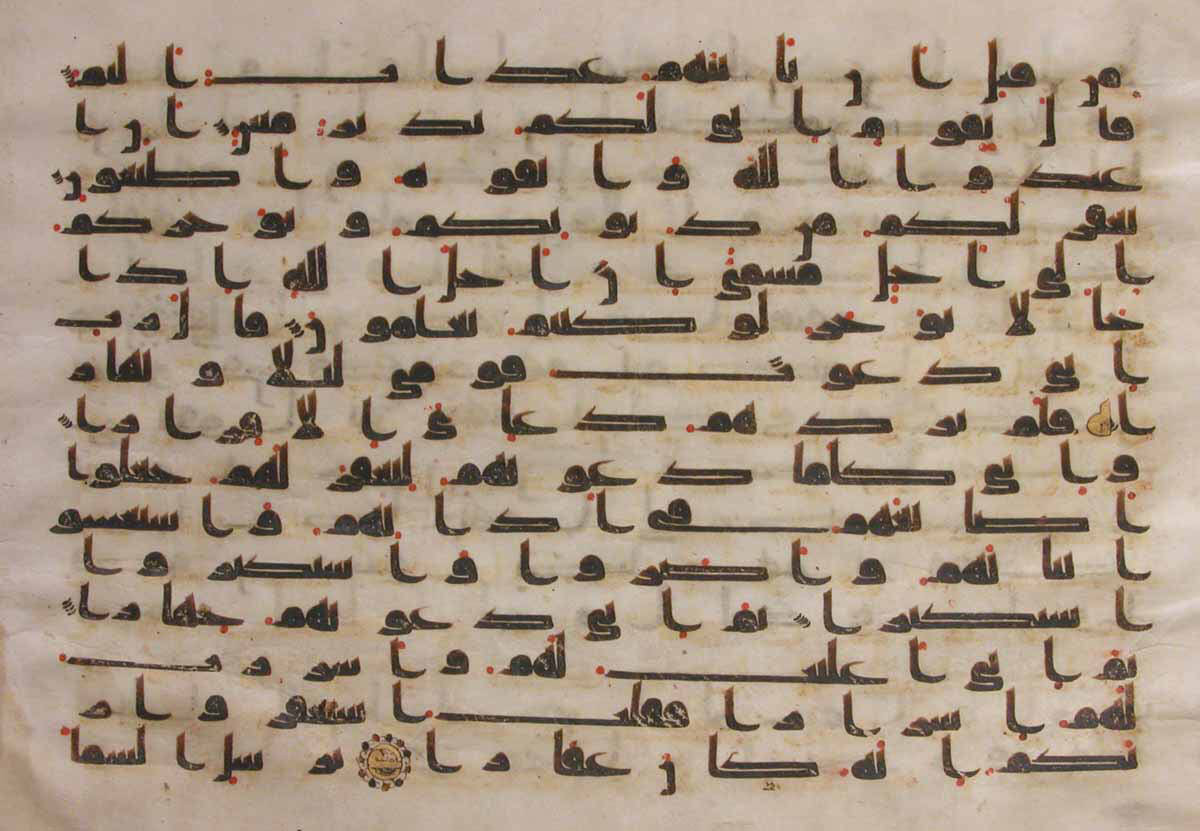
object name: section from a non illustrated manuscript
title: Section from a Qur'an Manuscript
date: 801-933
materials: gold, ink, parchment, watercolor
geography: egypt or iraq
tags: arabic,qur'an,calligraphy